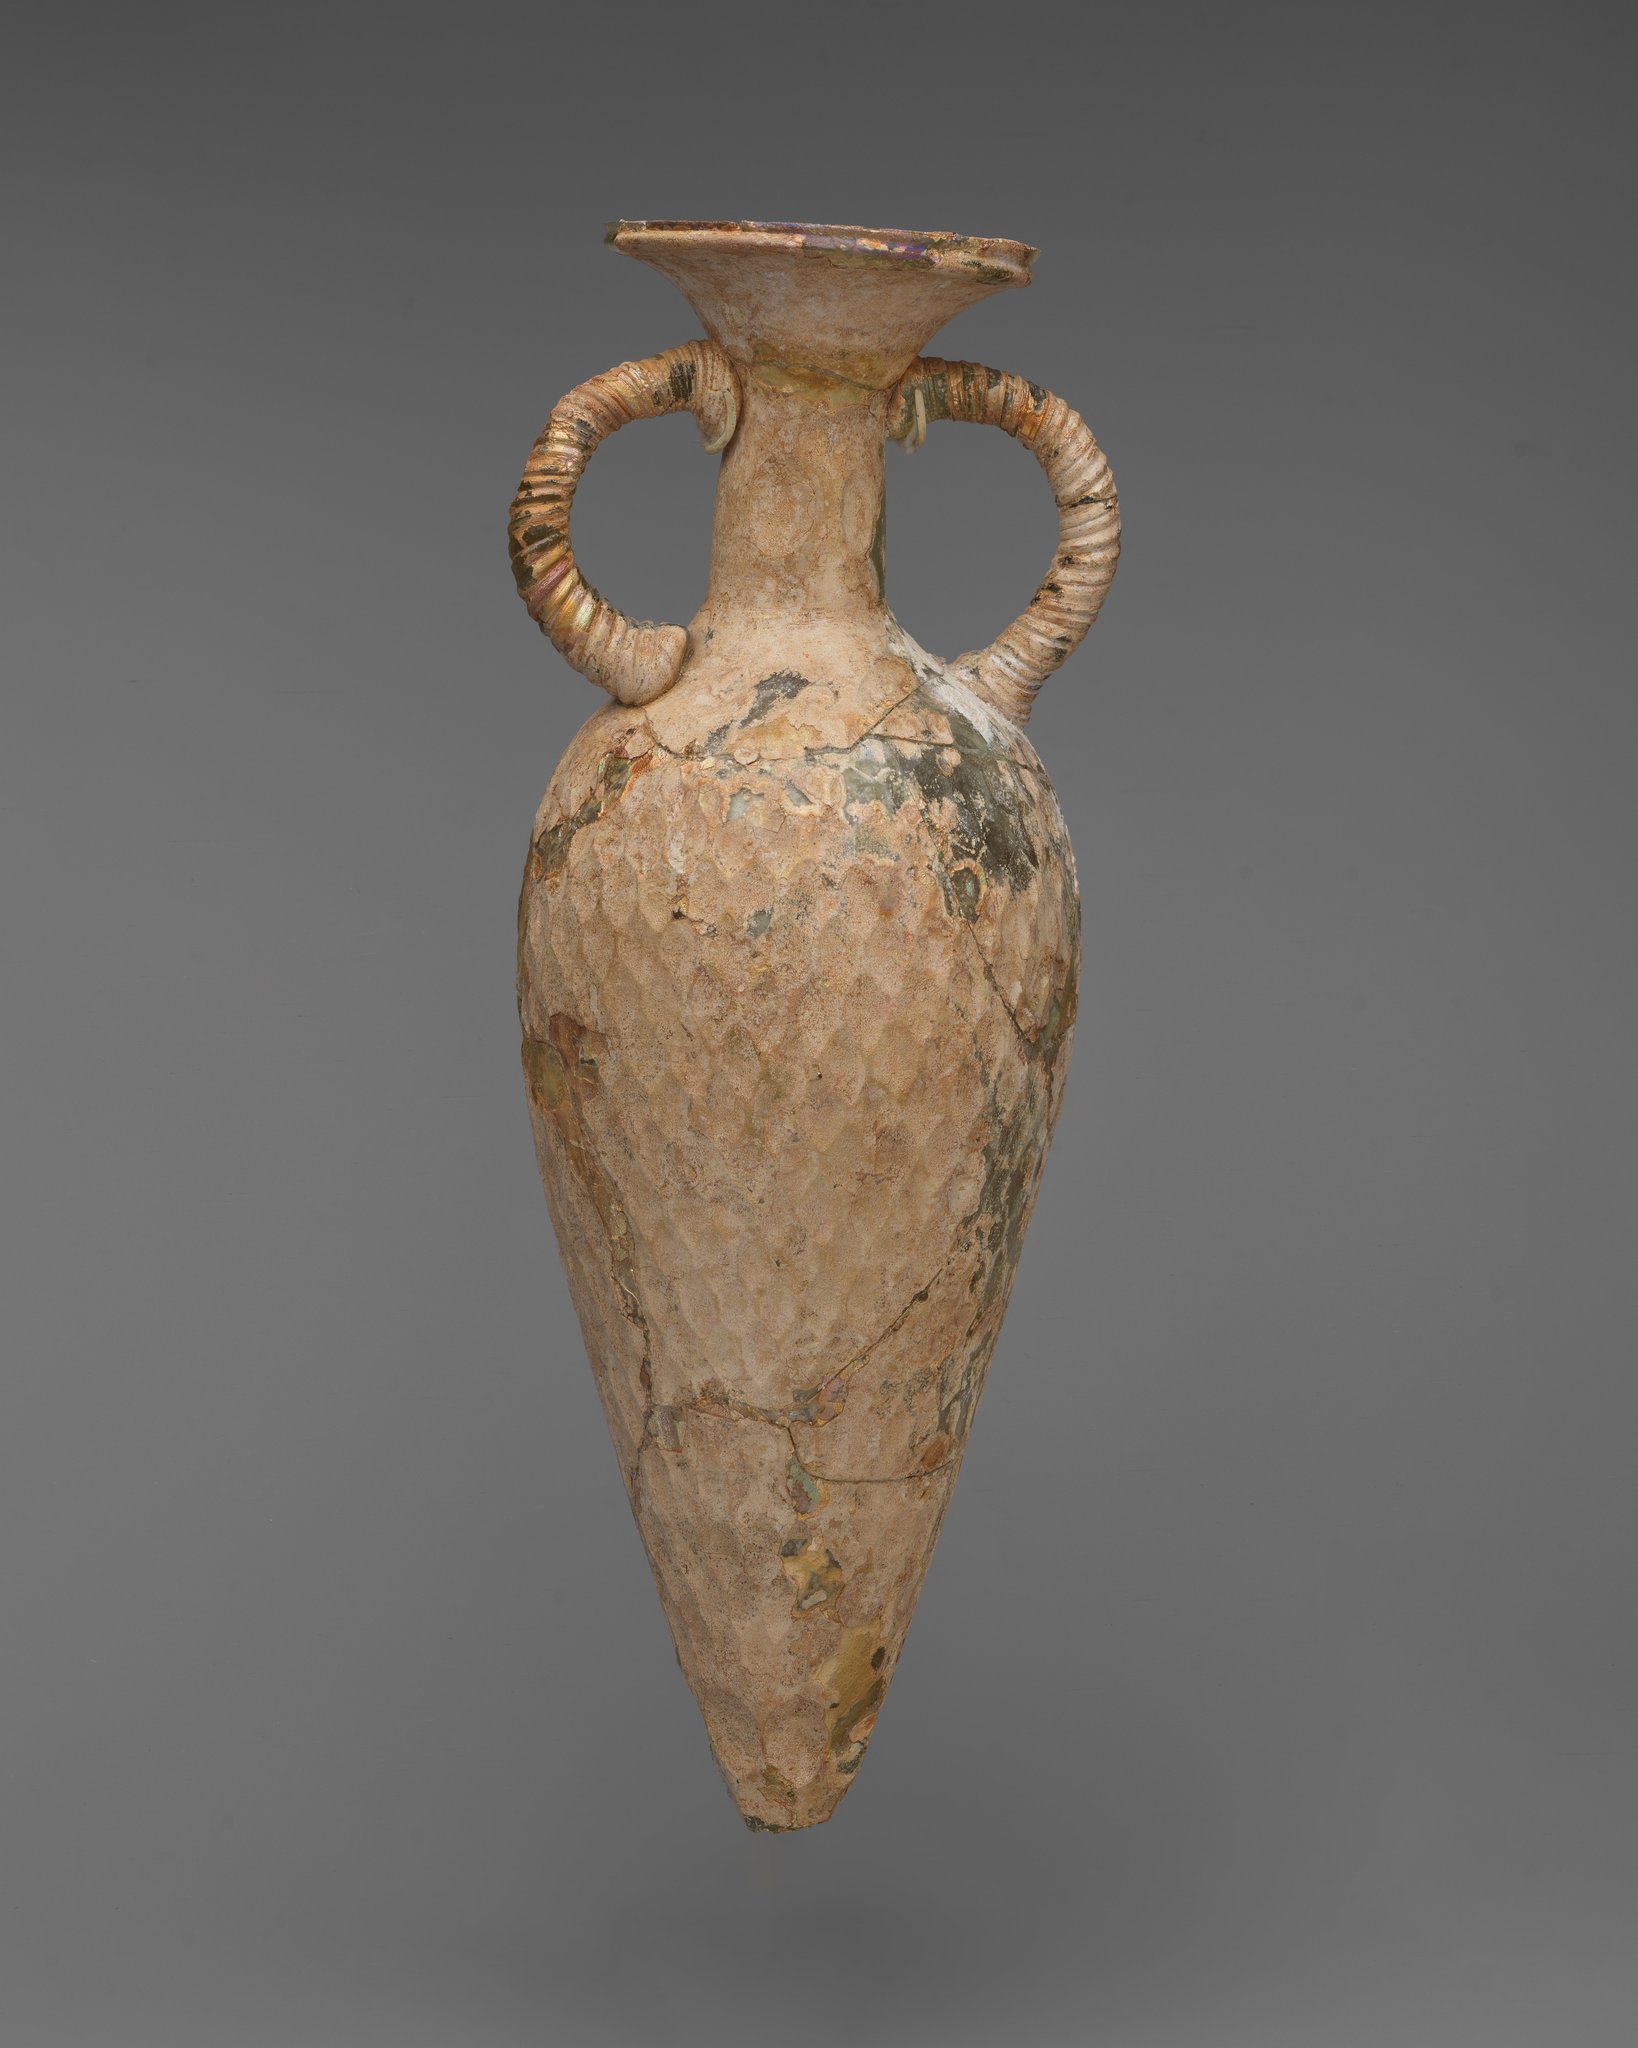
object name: vessel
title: Two-handled vessel with a pierced base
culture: sasanian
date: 301-500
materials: glass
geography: iran